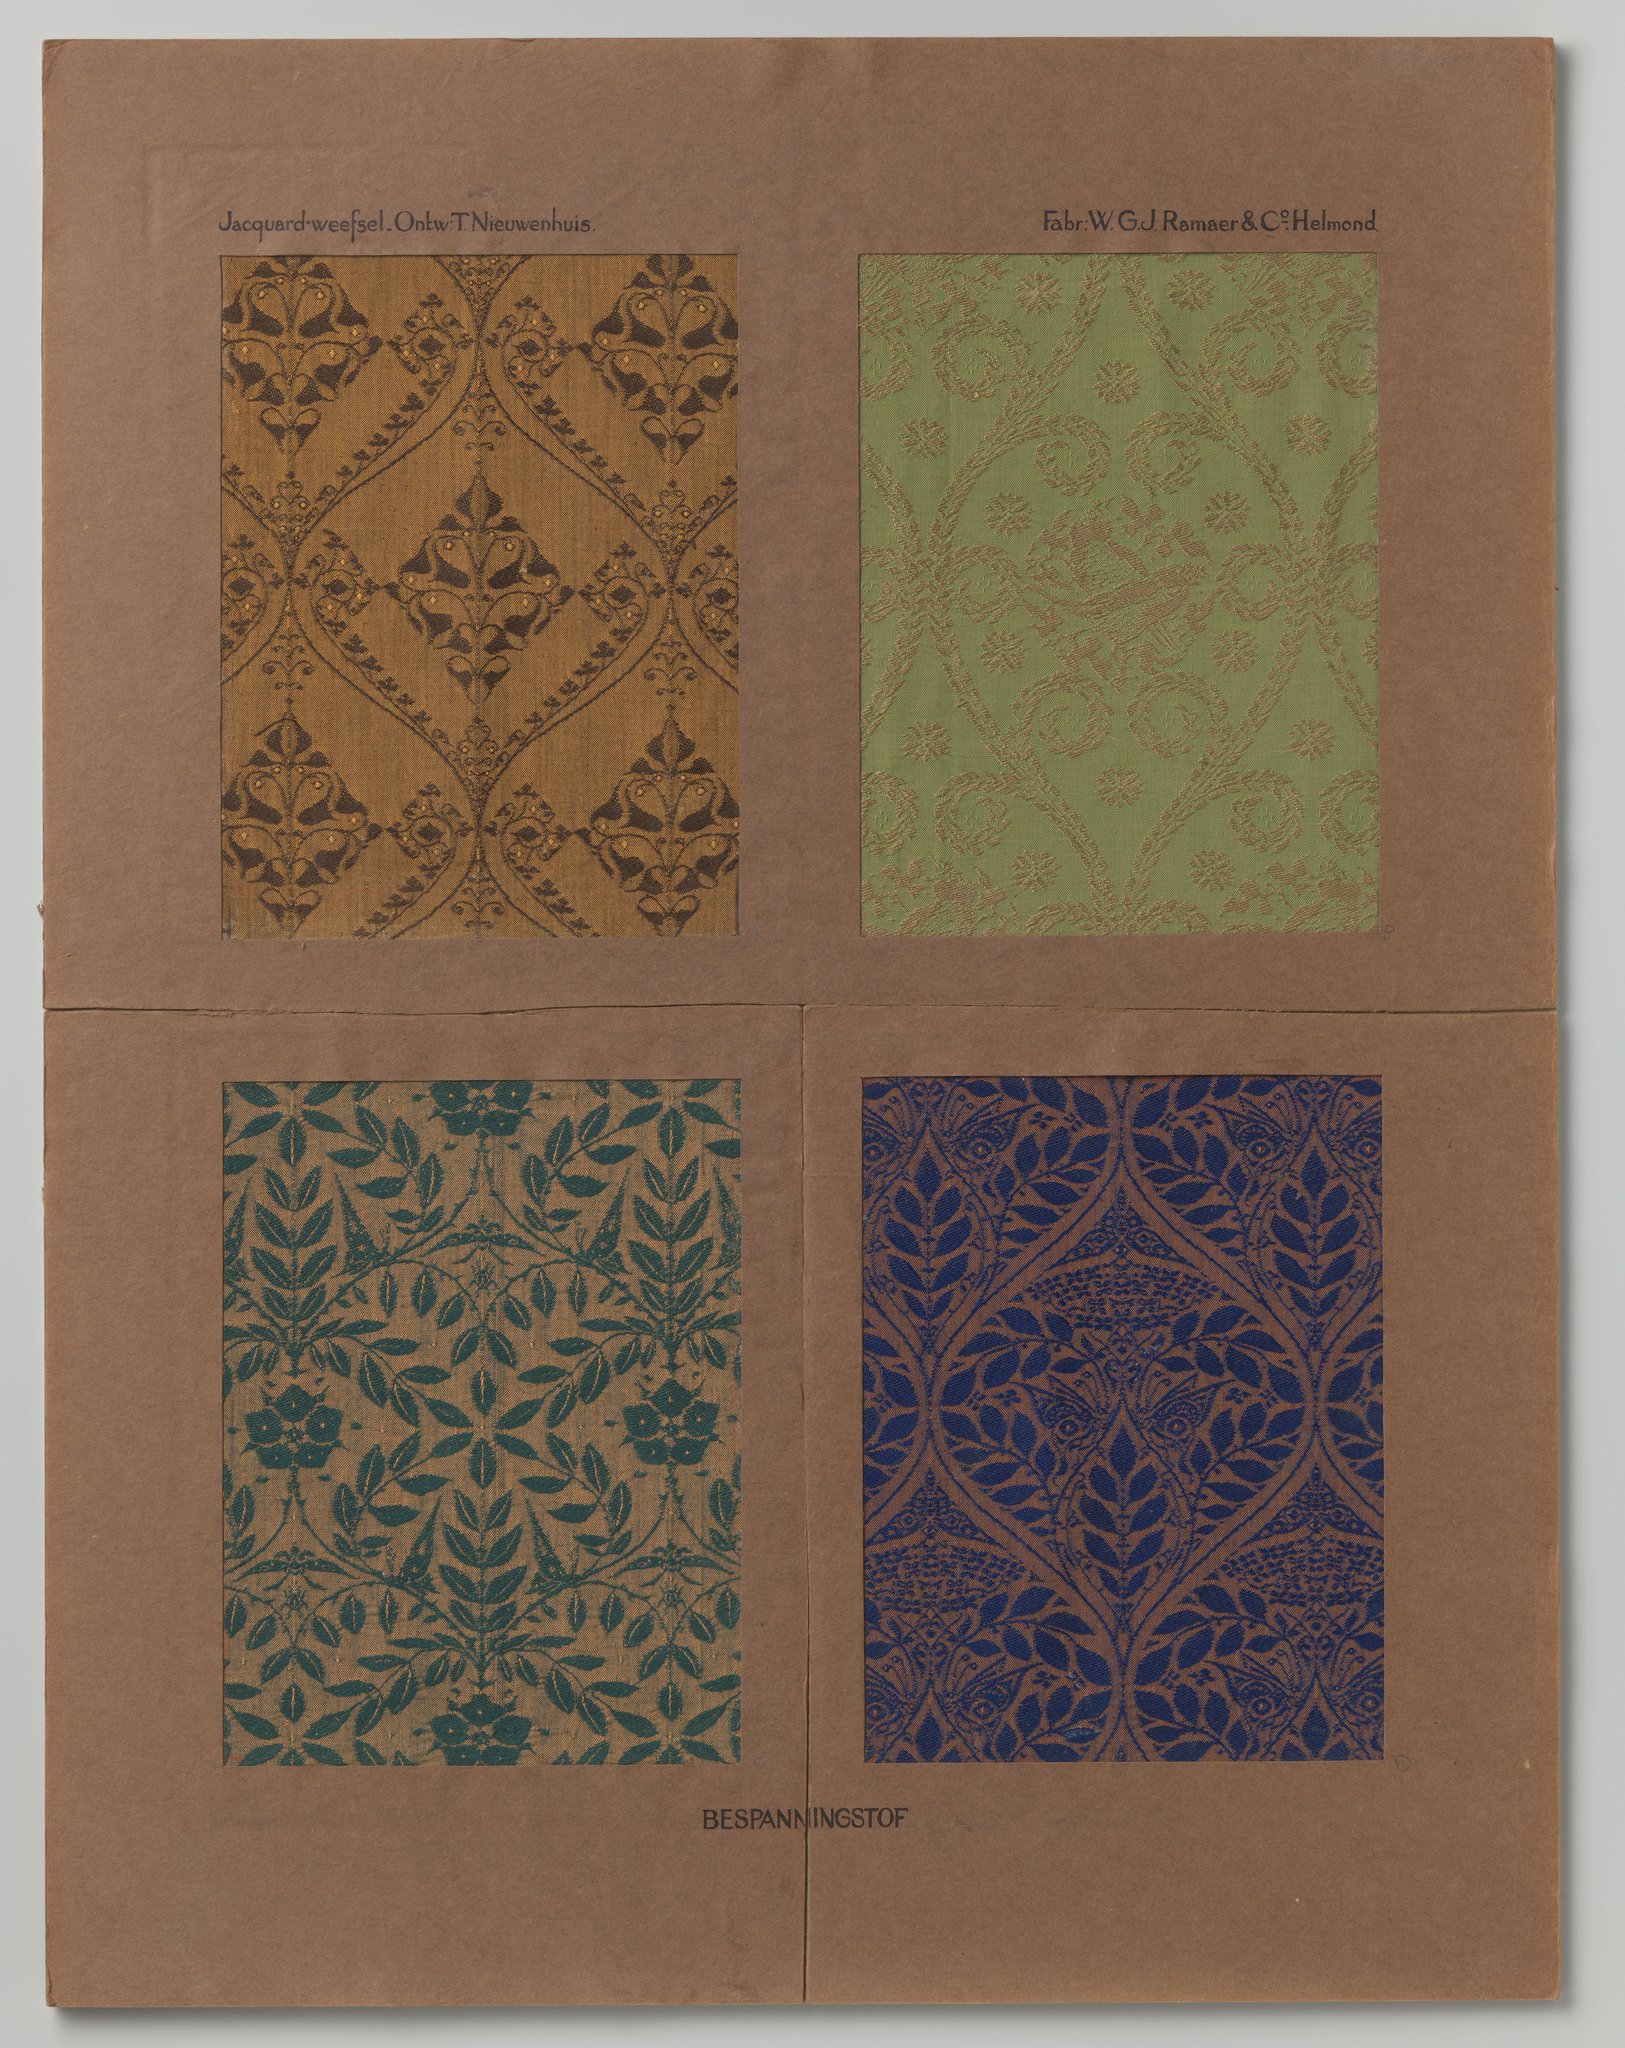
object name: upholstery fabric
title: Stalen bespanningsstof naar ontwerp van Theo Nieuwenhuis in passe-partout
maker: theo nieuwenhuis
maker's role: designer, draughtsman, print maker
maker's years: 1866-1951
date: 1910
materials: cardboard, cotton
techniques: jacquard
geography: helmond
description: Staalkaart met vier stalen bespanningsstof van jacquardgeweven katoen naar ontwerp van Theo Nieuwenhuis. In origineel passe-partout.